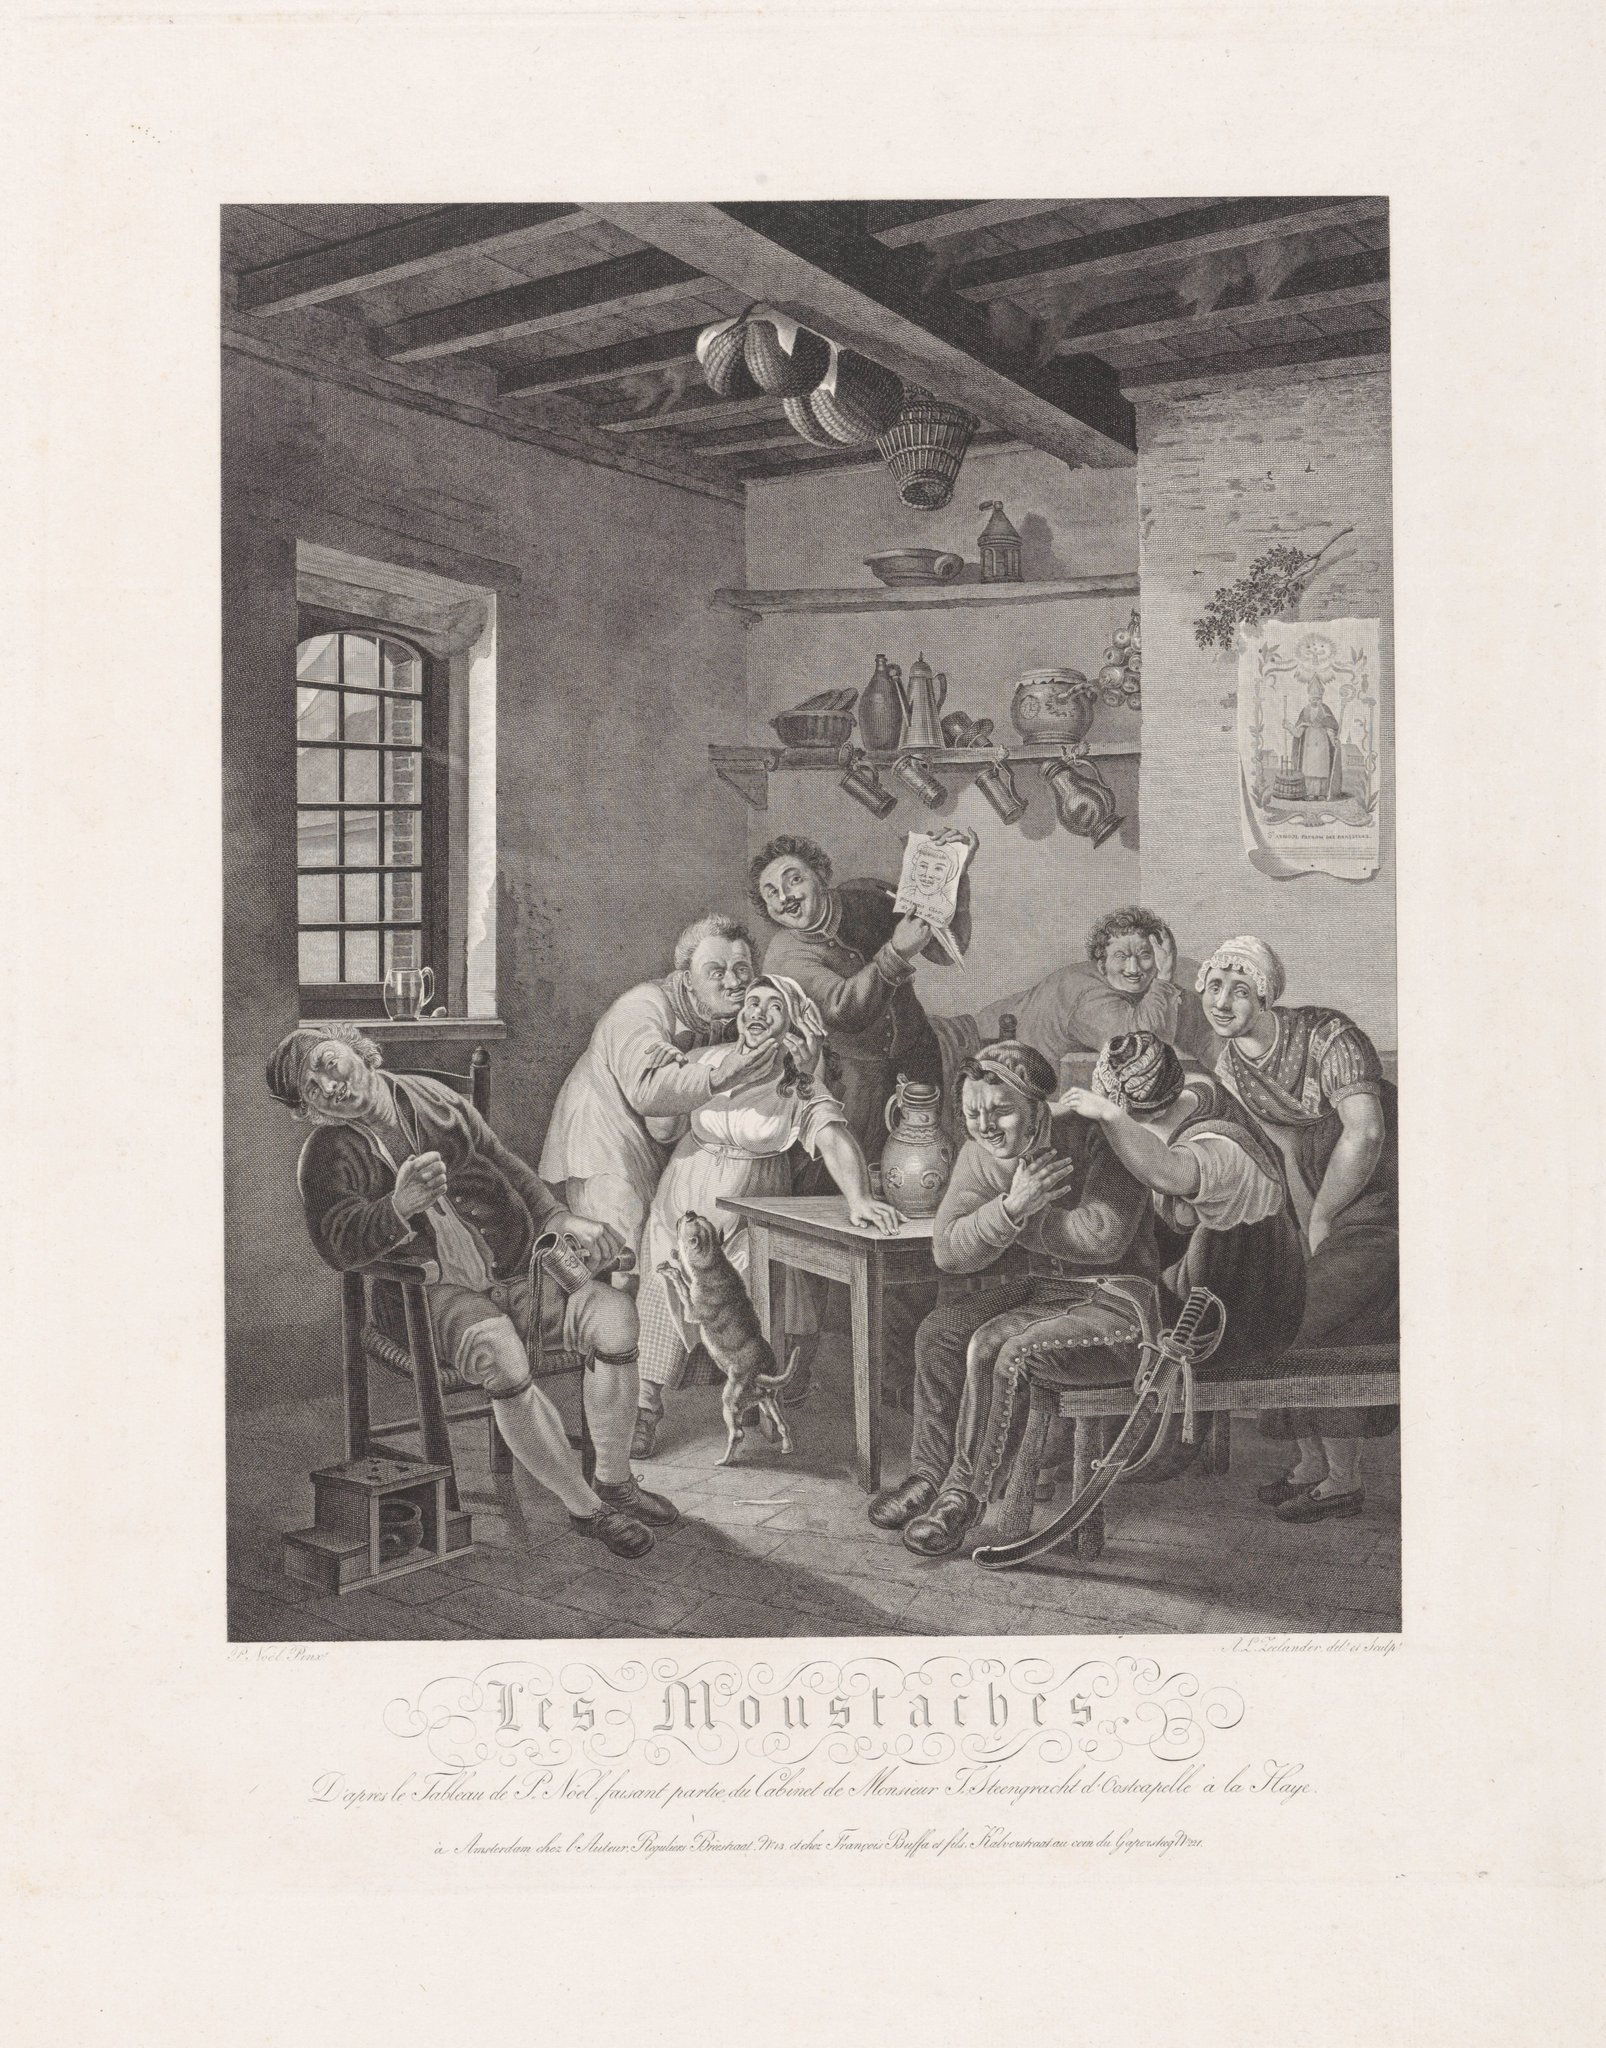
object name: print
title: Dronken gezelschap lacht om een vrouw met snor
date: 1804-1856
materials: paper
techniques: engraving, etching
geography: amsterdam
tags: middelburg, laughing, drunkenness, moustache - aa - ~ women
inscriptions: collector's mark: Lugt 2228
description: In een interieur zit een dronken gezelschap rond een tafel. Op het gezicht van een vrouw heeft de man met een schrijfveer, die een tekening van een vrouw met snor toont, een snor getekend. Een man naast haar grijpt de vrouw vast en trekt een grimas. Andere mensen huilen van het lachen om de situatie. De man links op de voorgrond houdt zijn pul zo scheef dat de drank eruit stroomt. Aan de muur hangt een prent van de heilige Arnoldus van Soissons als patroonheilige van de bierbrouwers. Onderaan in de marge de titel en een tekst in het Frans, waarin staat dat het schilderij zich bevindt in de collectie van Johan Steengracht van Oostcapelle in Den Haag.